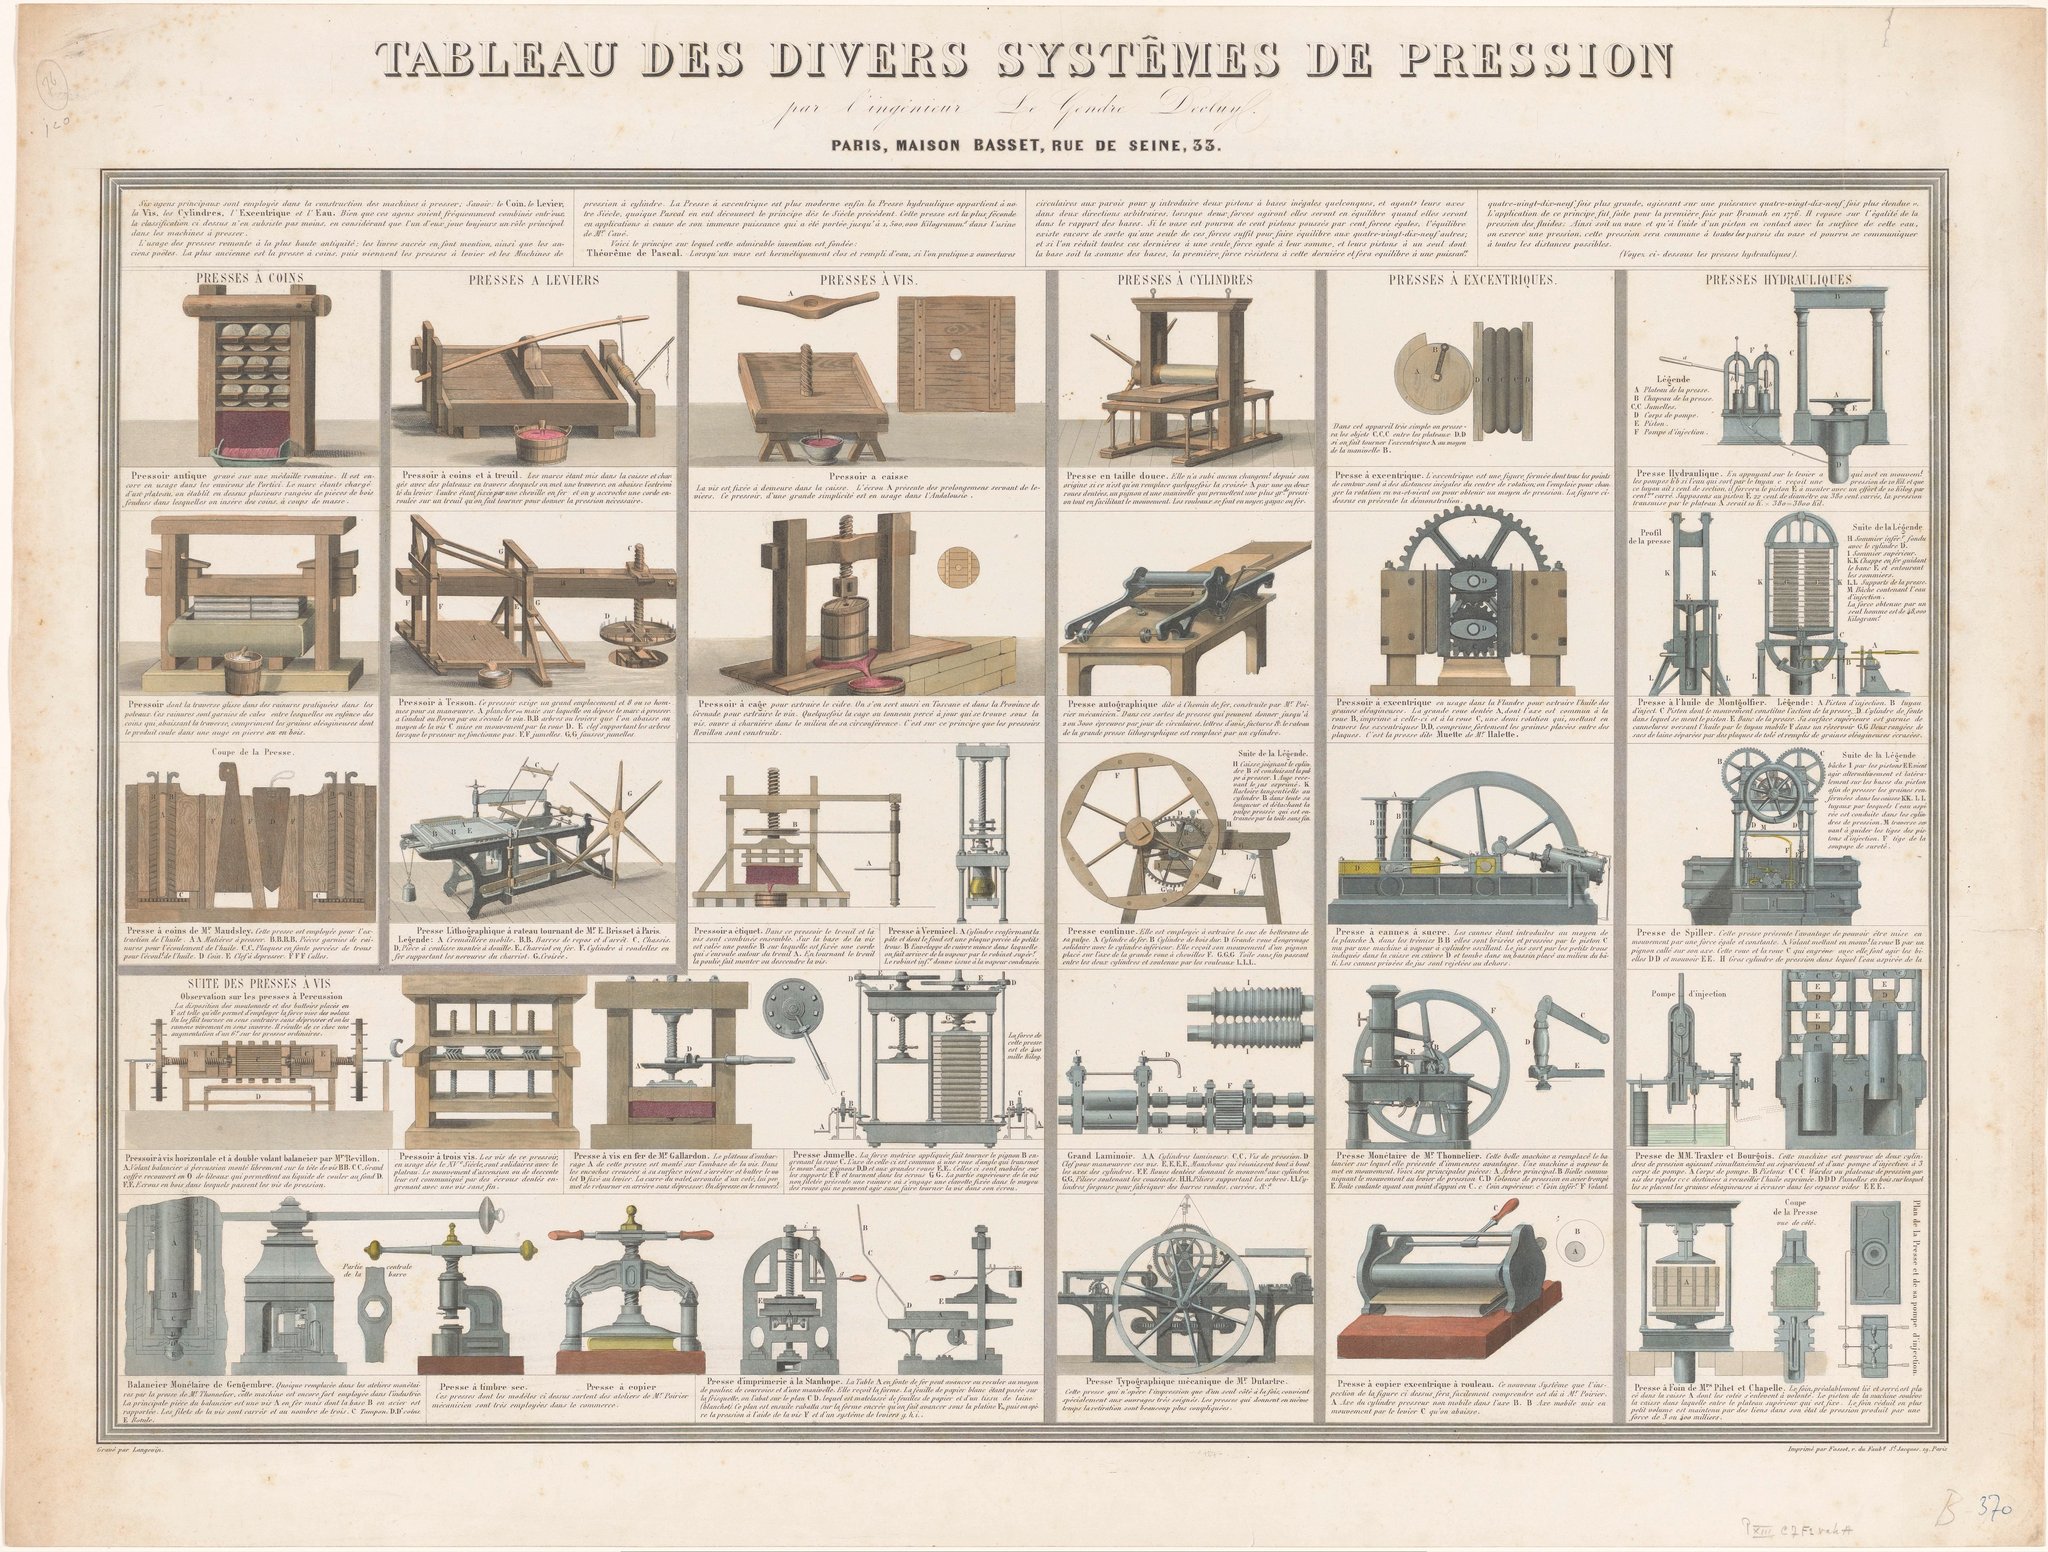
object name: print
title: Drukpersen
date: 1850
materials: paper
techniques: hand coloring, lithograph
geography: paris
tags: tools, aids, implements ~ crafts and industries: press, printing press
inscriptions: collector's mark: Lugt 2228, collector's mark: Lugt 4779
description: Overzicht van drieëndertig verschillende drukpersen, waaronder een plaatpers, een lithografische pers en verschillende boekdrukpersen.